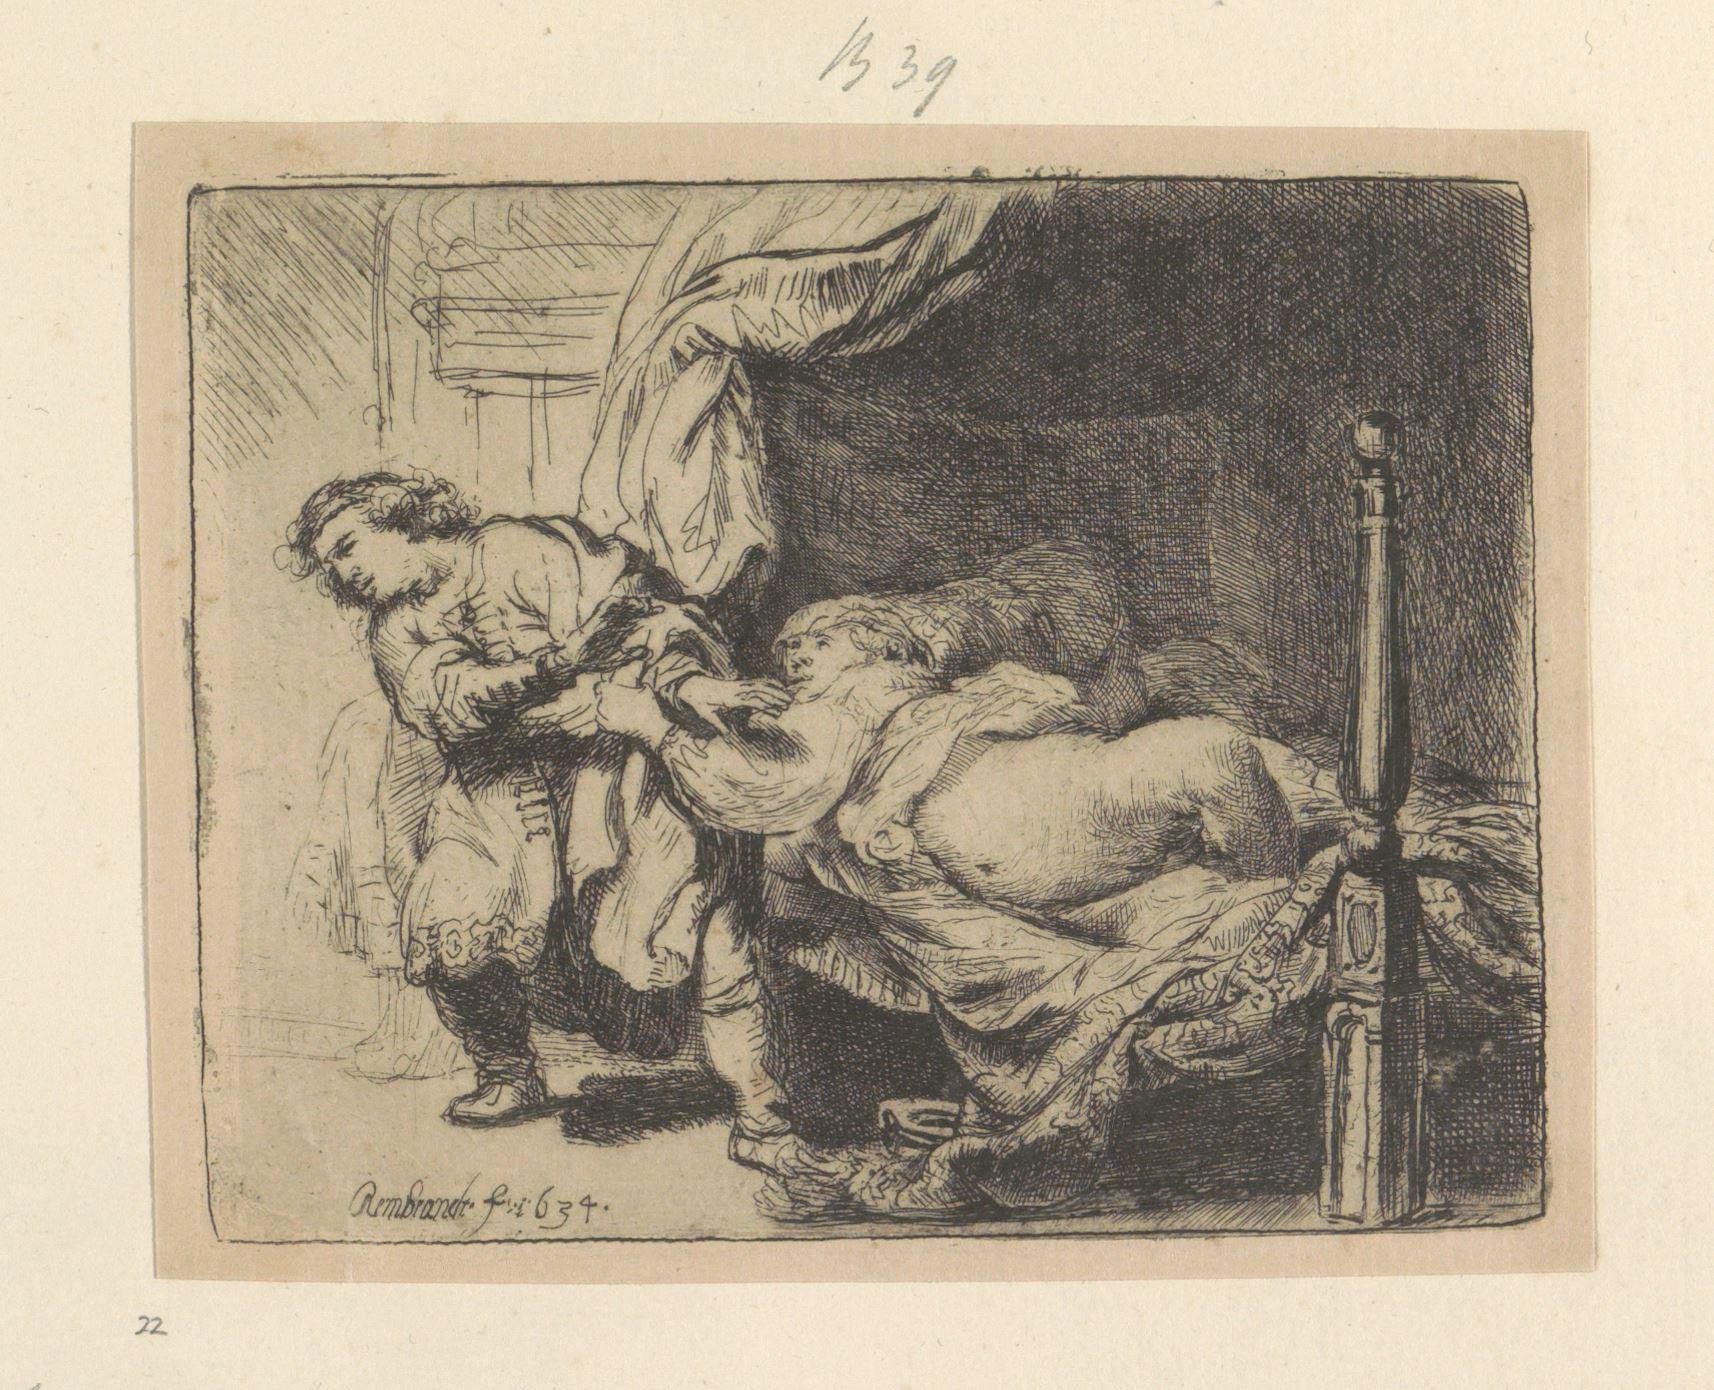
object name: album leaf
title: Recueil de quatre-vingt-cinq estampes originales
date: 1634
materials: paper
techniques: etching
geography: paris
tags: potiphar's wife catches joseph by his robe, usually while lying in bed; joseph escapes leaving his cloak behind in her hands (possibly with a naked child lying in a crib)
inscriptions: date